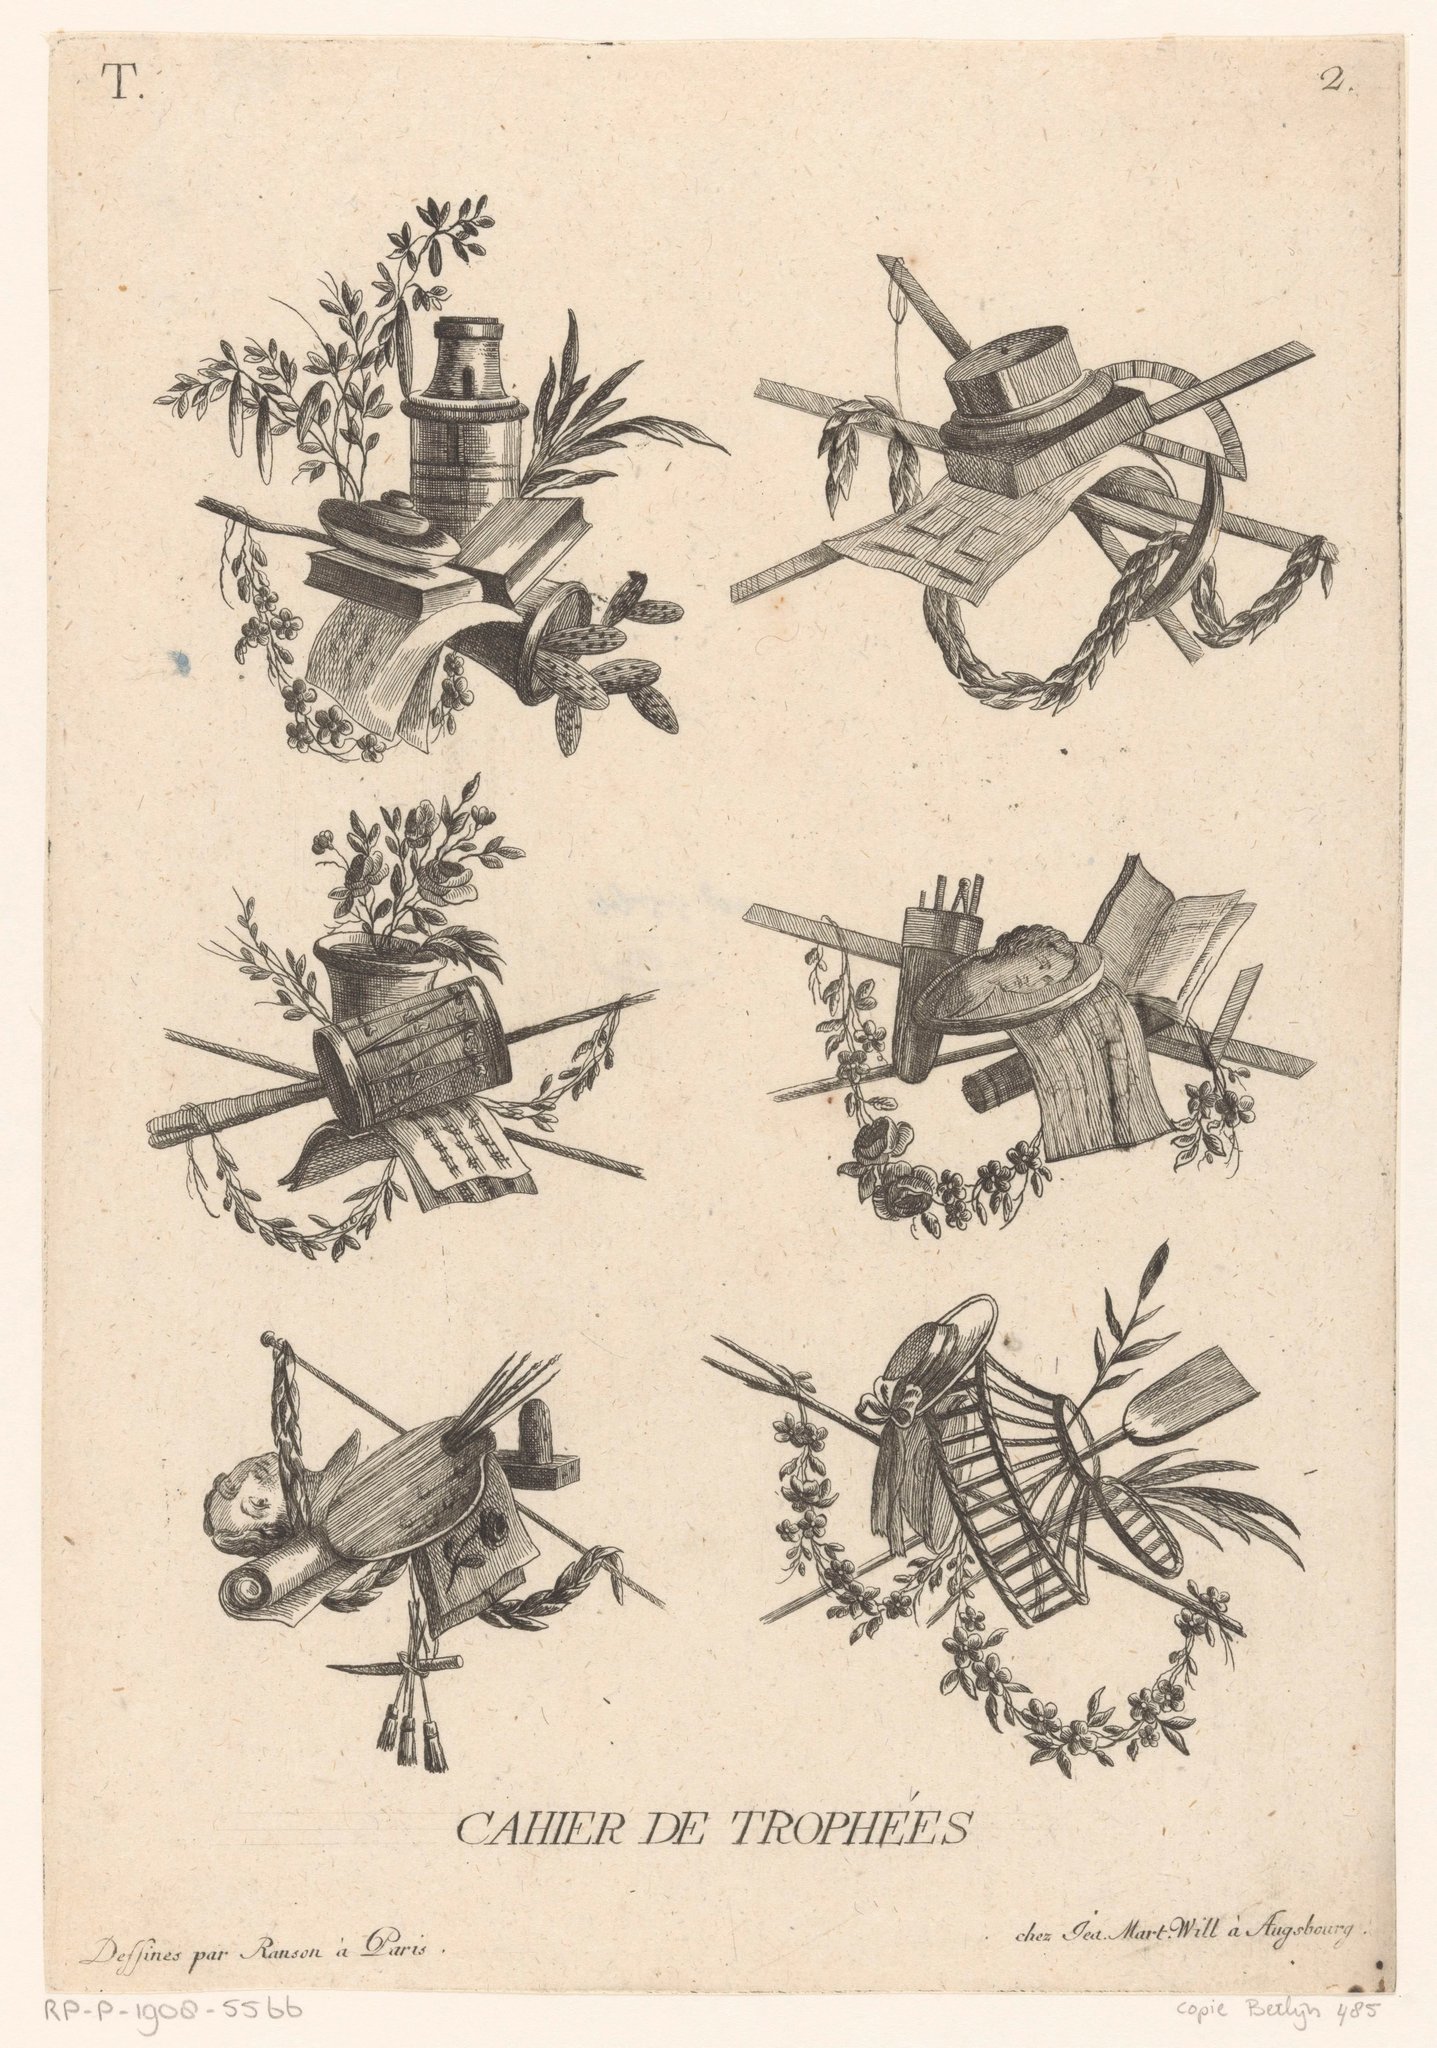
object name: print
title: Trofeeën met attributen behorend bij architectuur, beeldhouwkunst en schilderkunst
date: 1746-1806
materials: paper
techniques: etching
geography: paris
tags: trophy, i.e.: decorative arrangement of symbolic or typical objects ~ ornament, 'pictura', symbolic representations, allegories and emblems ~ painting; 'pittura' (ripa), 'sculptura', symbolic representations, allegories and emblems ~ sculpture; 'scoltura' (ripa), 'architectura', symbolic representations, allegories and emblems ~ architecture; 'architettura' (ripa)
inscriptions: collector's mark: Lugt 2228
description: Zes trofeeën met diverse attributen zoals attributen behorend bij architectuur, beeldhouwkunst en schilderkunst en herdersattributen.